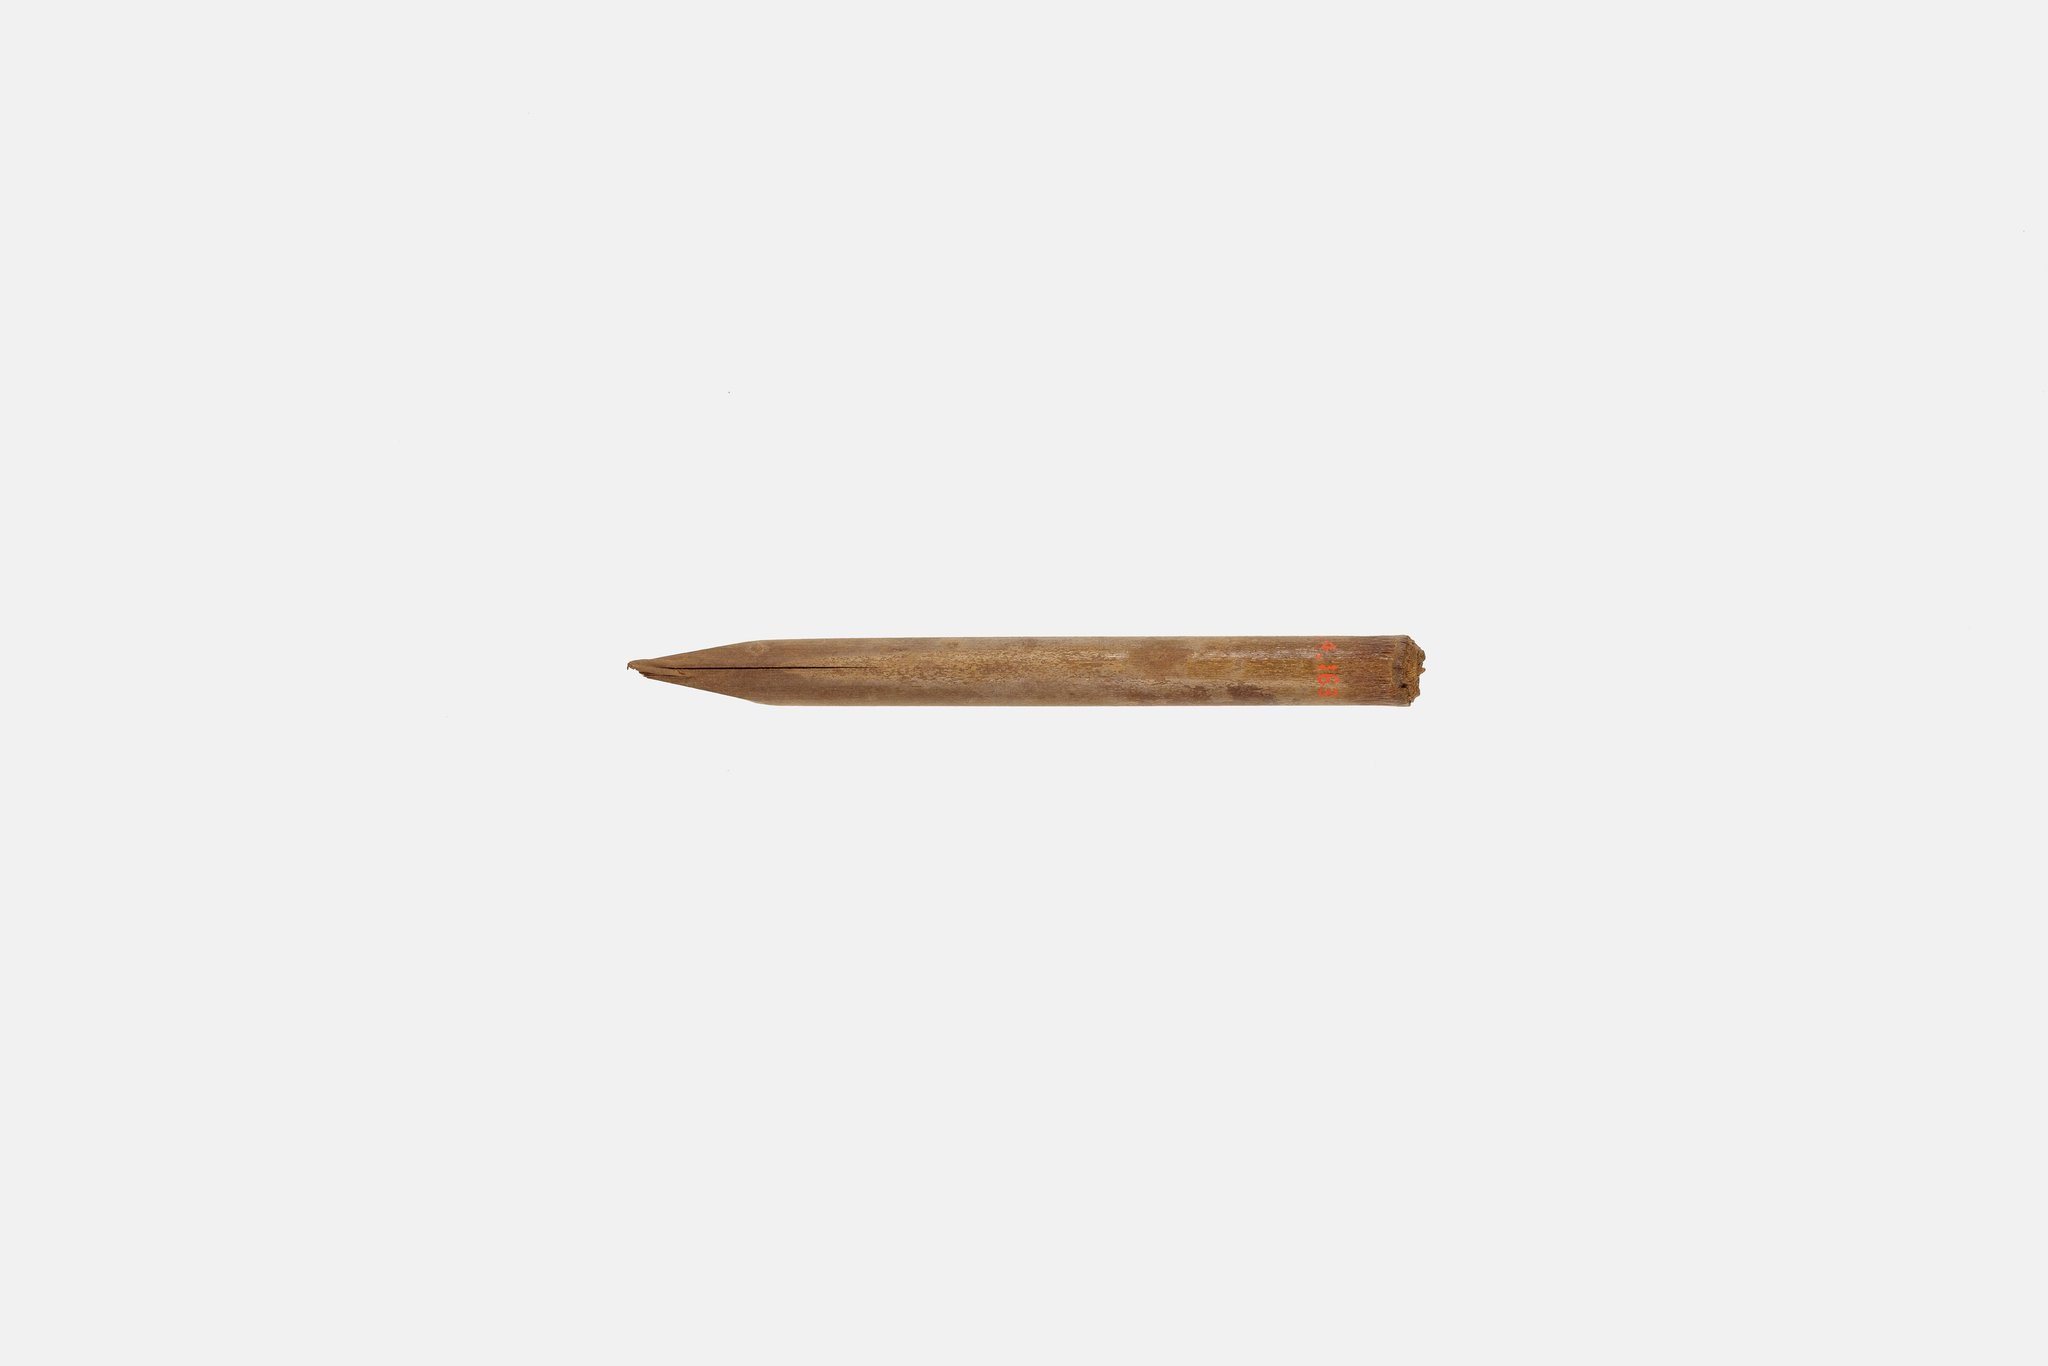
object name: pen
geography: egypt